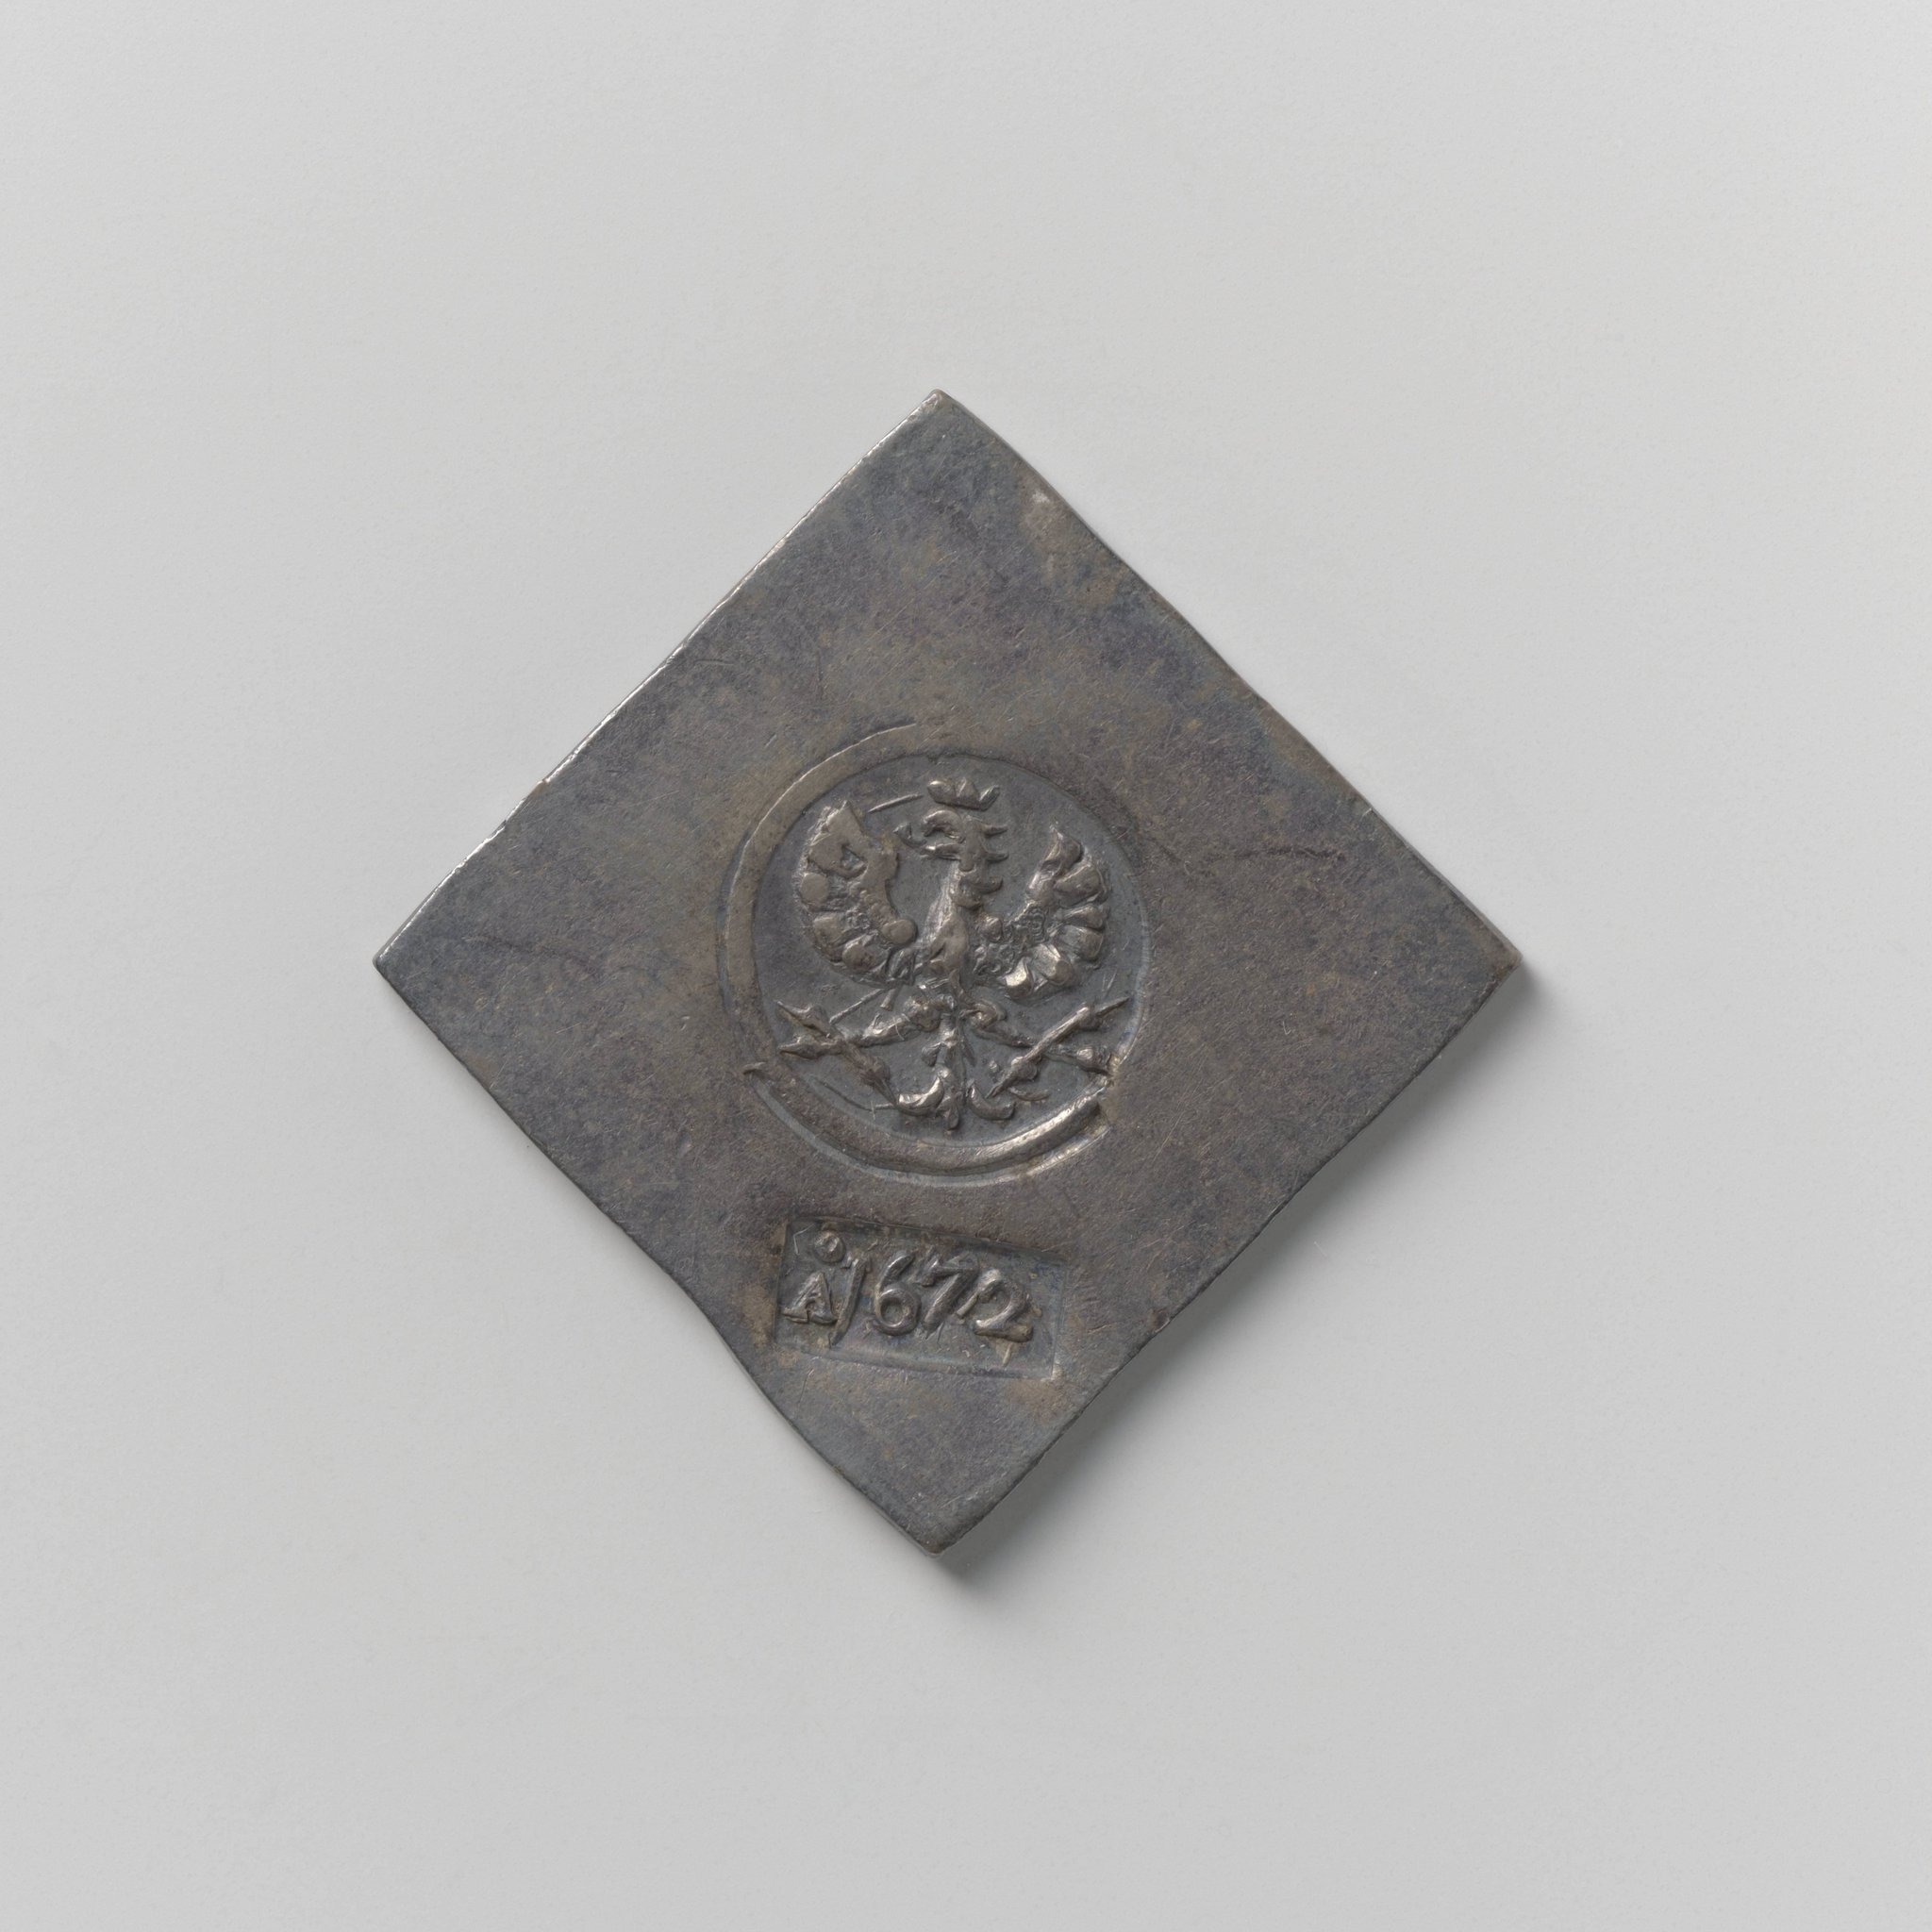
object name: coin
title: kwart daalder, noodmunt uit Deventer, vervaardigd tijdens het beleg uit het raadszilver ter betaling van de oorlogskosten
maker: Anonymous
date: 1672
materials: silver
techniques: striking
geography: kampen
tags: deventer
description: eenzijdige, ruitvormige noodmunt. Voorzijde: twee stempels: grote, ronde stempel: gekroonde adelaar; daaronder: rechthoekige stempel met jaartal. Keerzijde: blanco